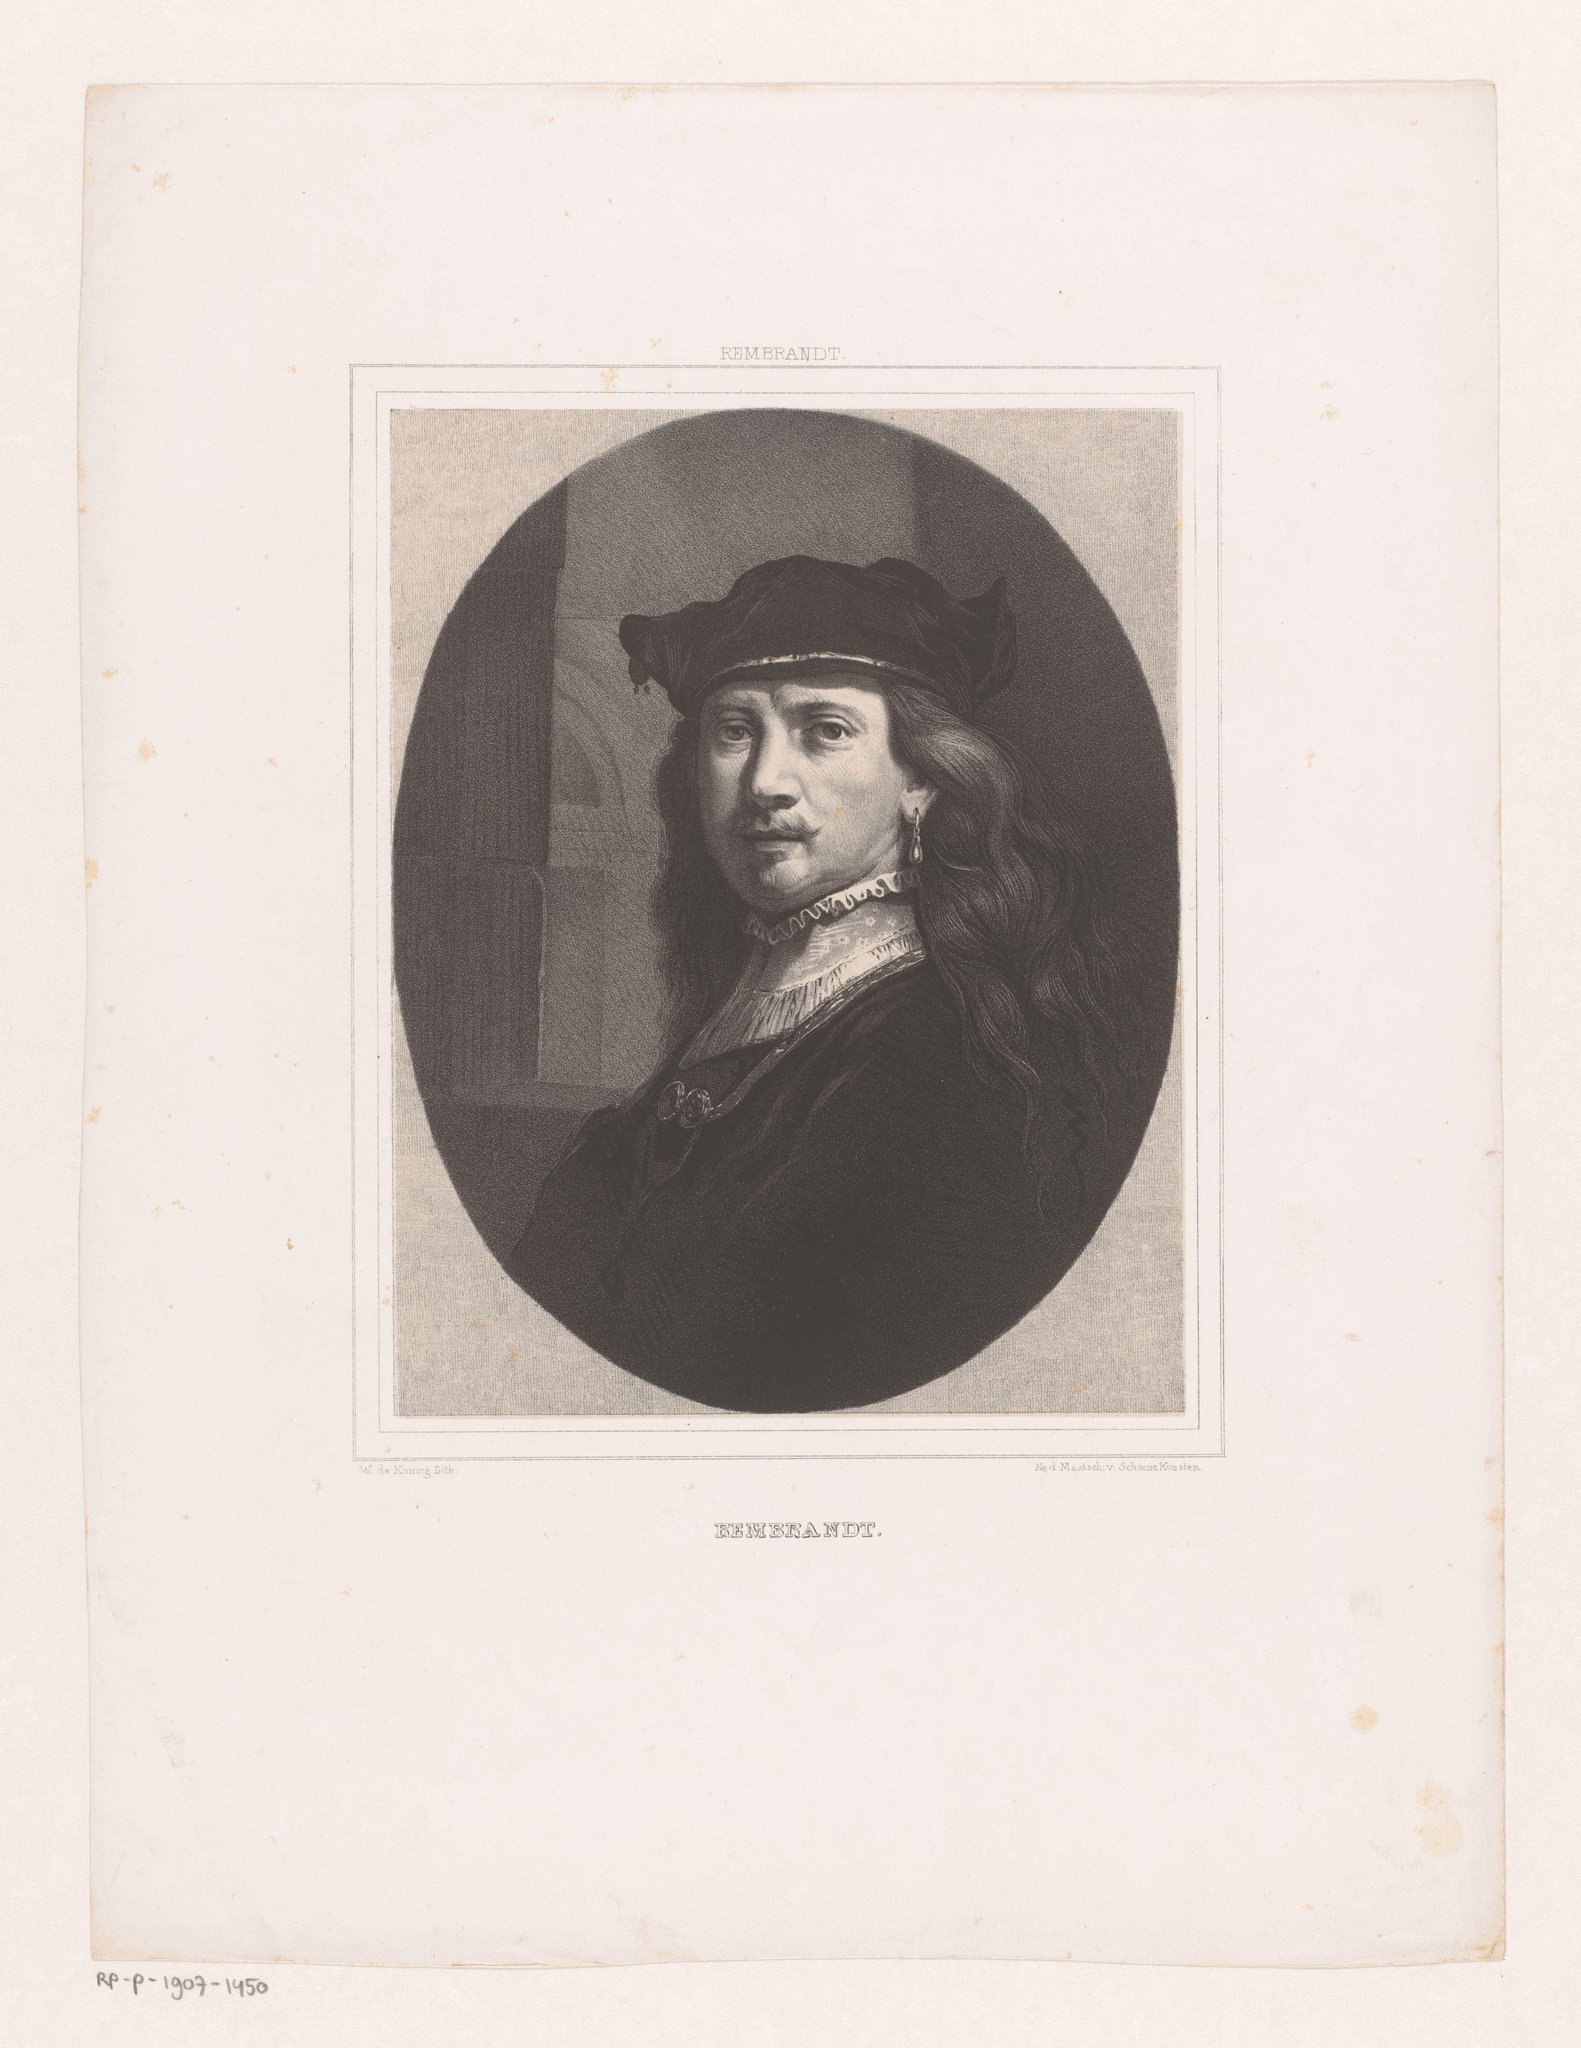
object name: print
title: Zelfportret Rembrandt met een architectonische achtergrond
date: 1840-1843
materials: paper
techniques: tone lithography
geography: the hague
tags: portrait, self-portrait of artist, head-gear: beret, ear-rings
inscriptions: collector's mark: Lugt 2228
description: Het schilderij is toegeschreven aan Rembrandt en het atelier van Rembrandt. Het bevindt zich in Musée du Louvre. Deze prent werd uitgegeven in De Kunstkronijk 2 (1841-1842), t.o. p. 10.